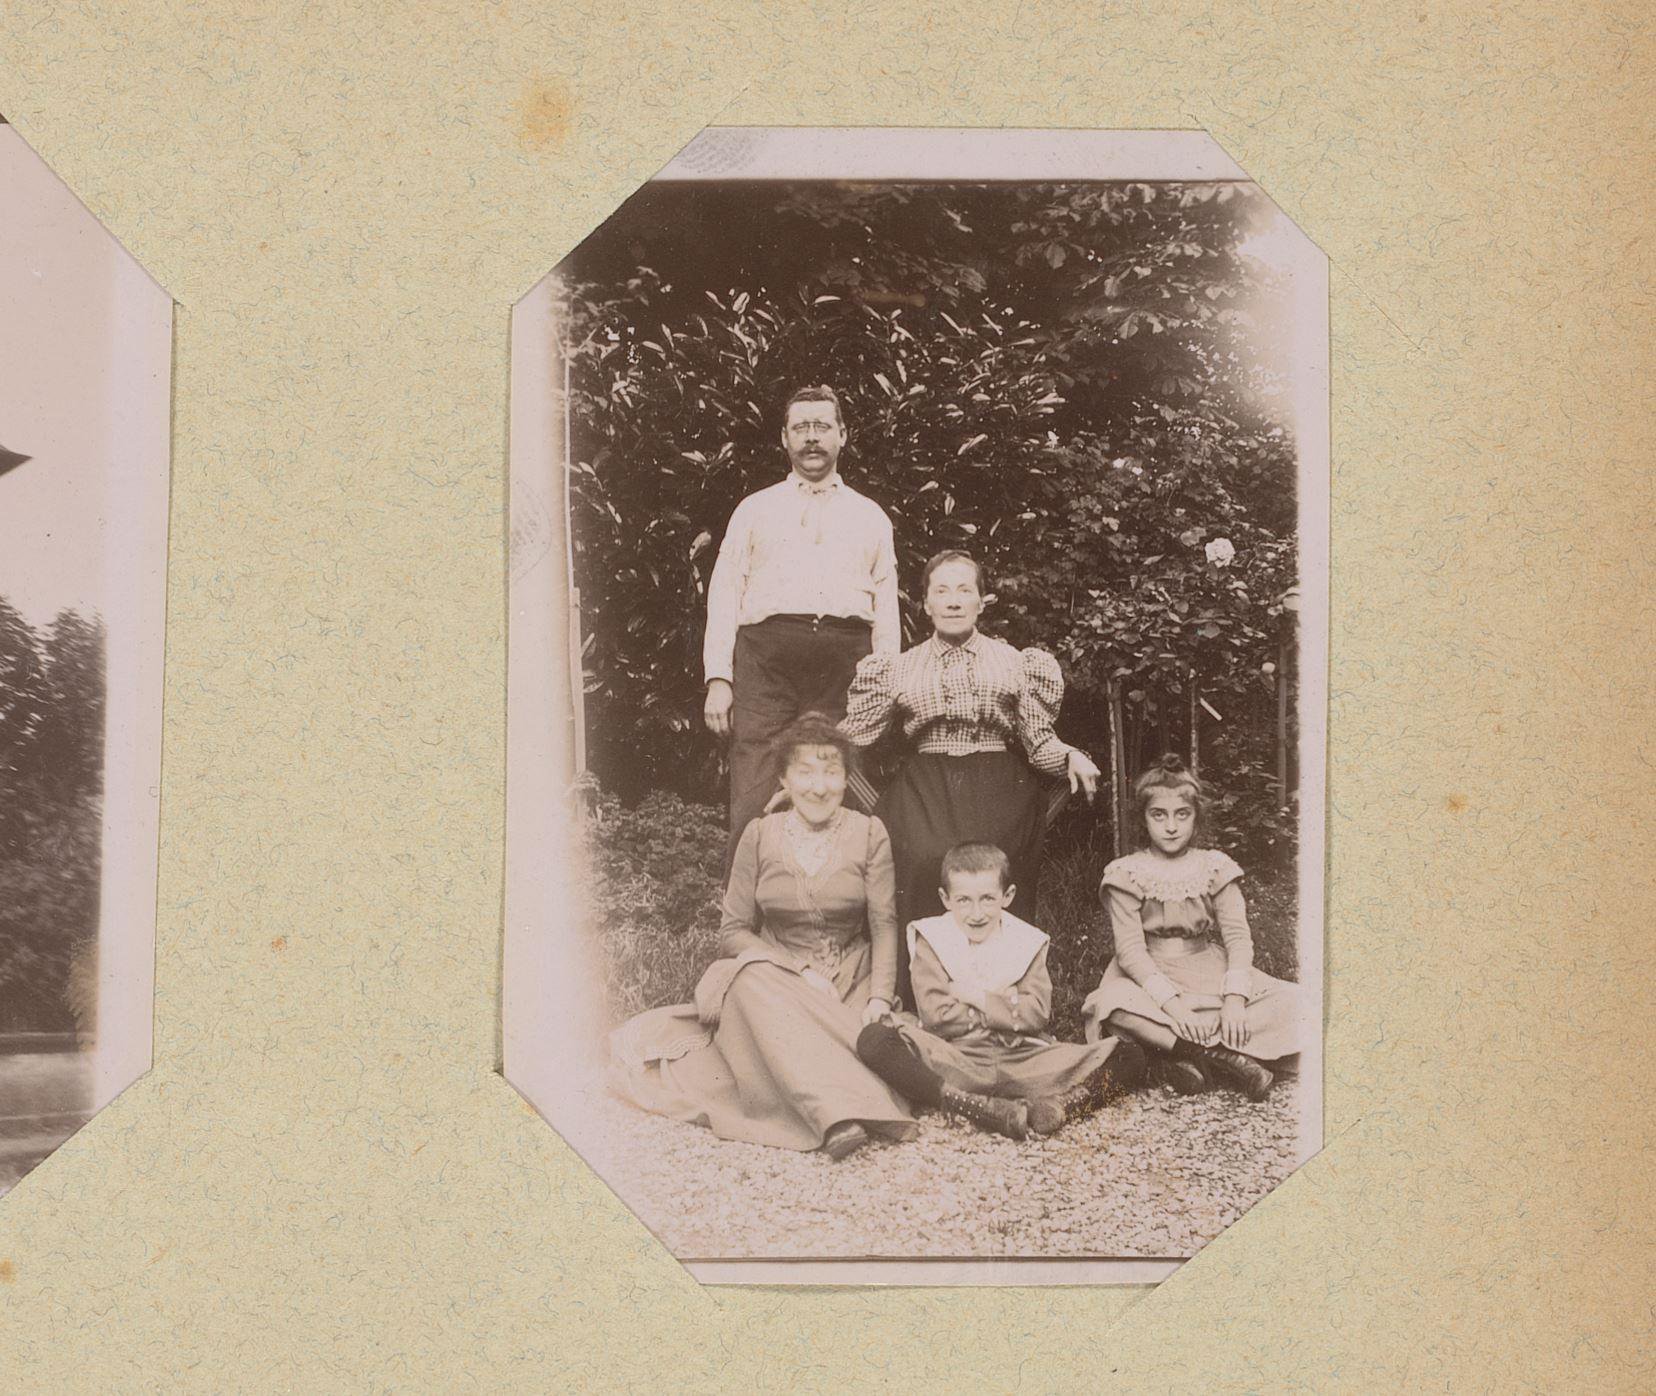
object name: album leaf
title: Groepsportret van een familie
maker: Anonymous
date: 1897-1900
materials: paper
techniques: gelatin silver print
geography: france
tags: family group, especially parents with their child(ren), anonymous historical person portrayed, france